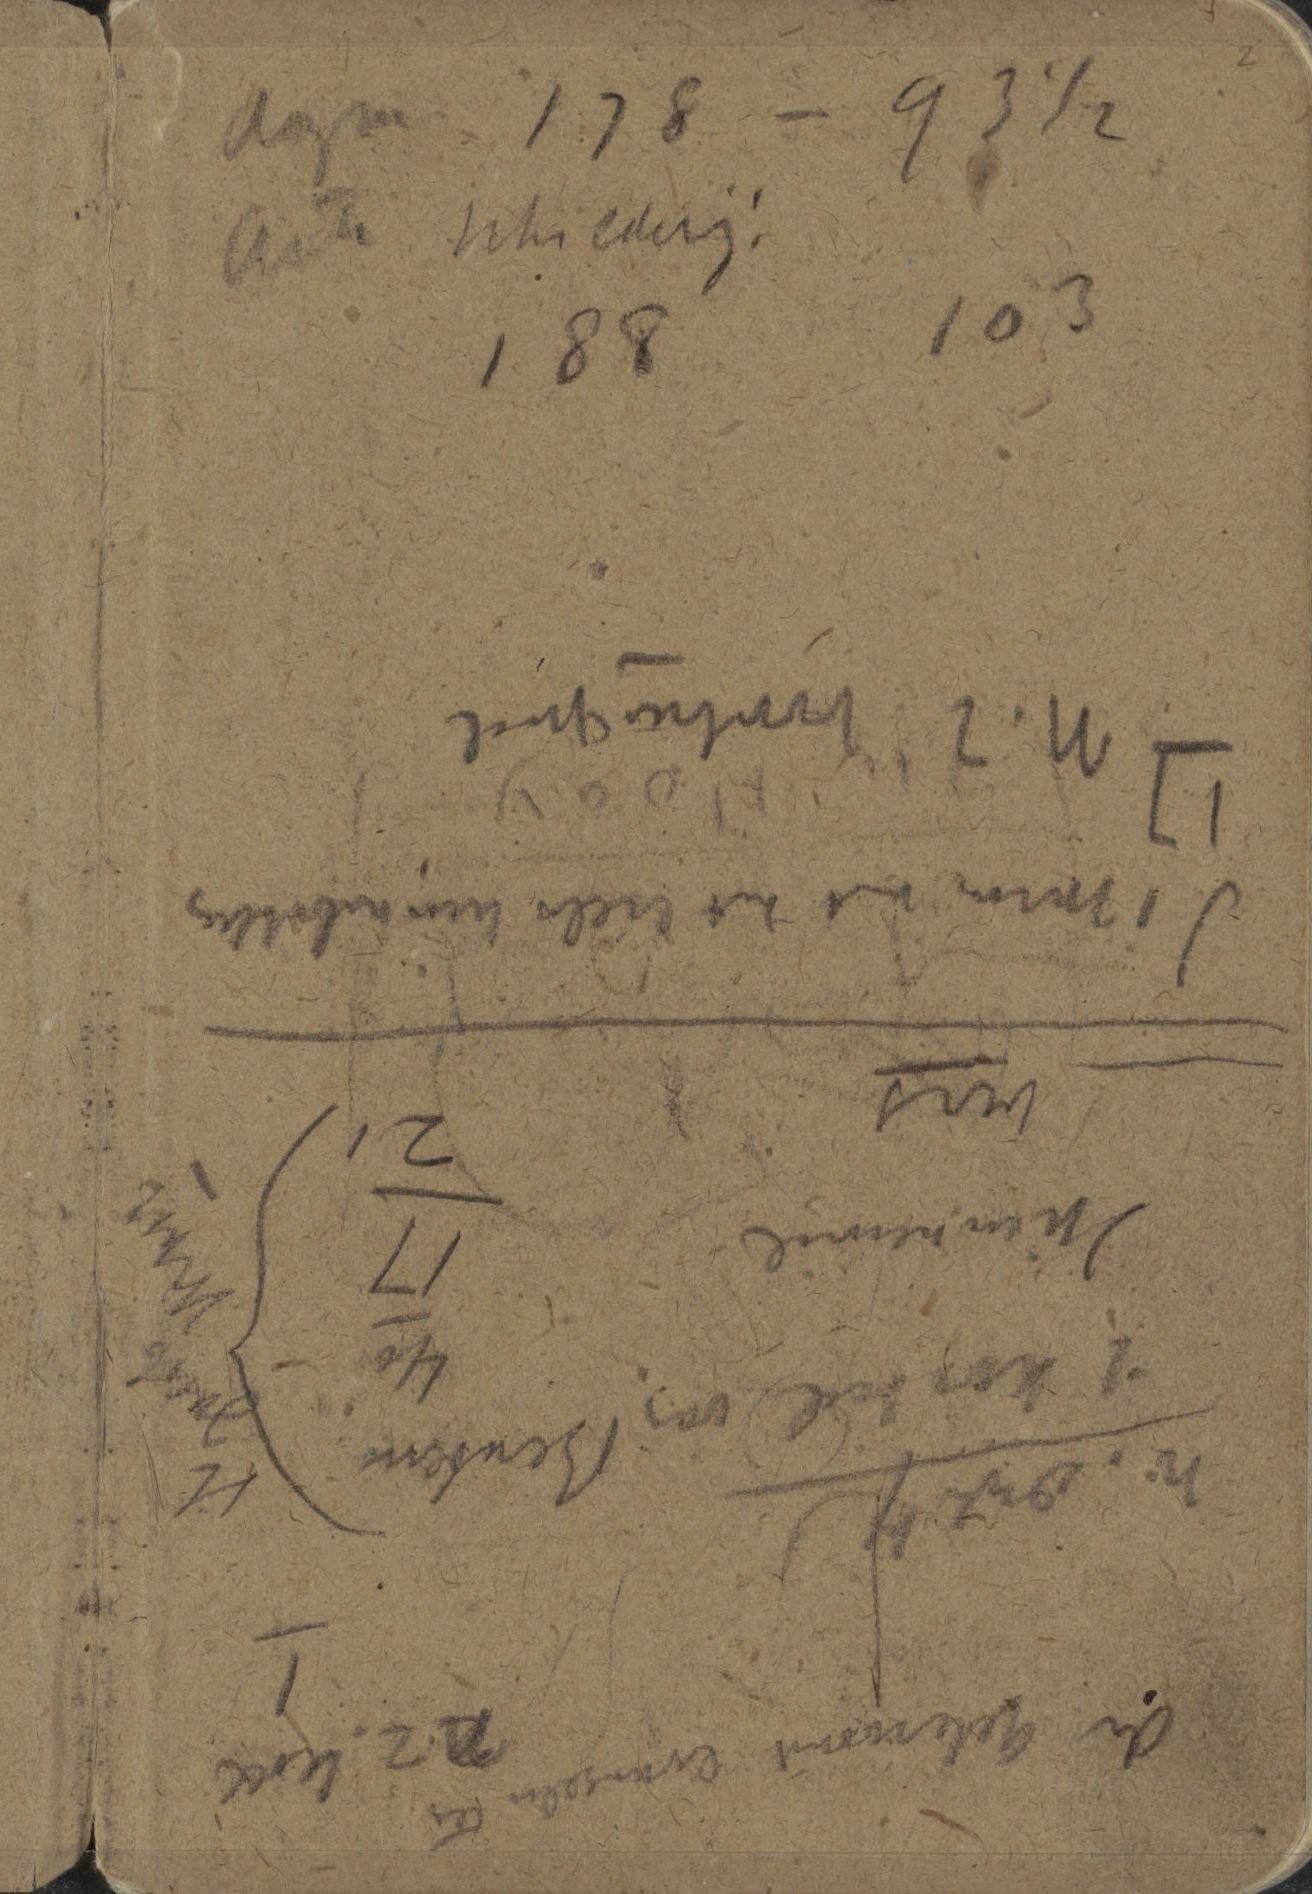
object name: endleaf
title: Annotaties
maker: george hendrik breitner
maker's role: draughtsman, painter, print maker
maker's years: 1857-1923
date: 1903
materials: chalk, paper, pencil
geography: amsterdam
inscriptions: annotation: ‘[...]’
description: Pagina 2, vrij schutblad, uit een schetsboek met 32 bladen.